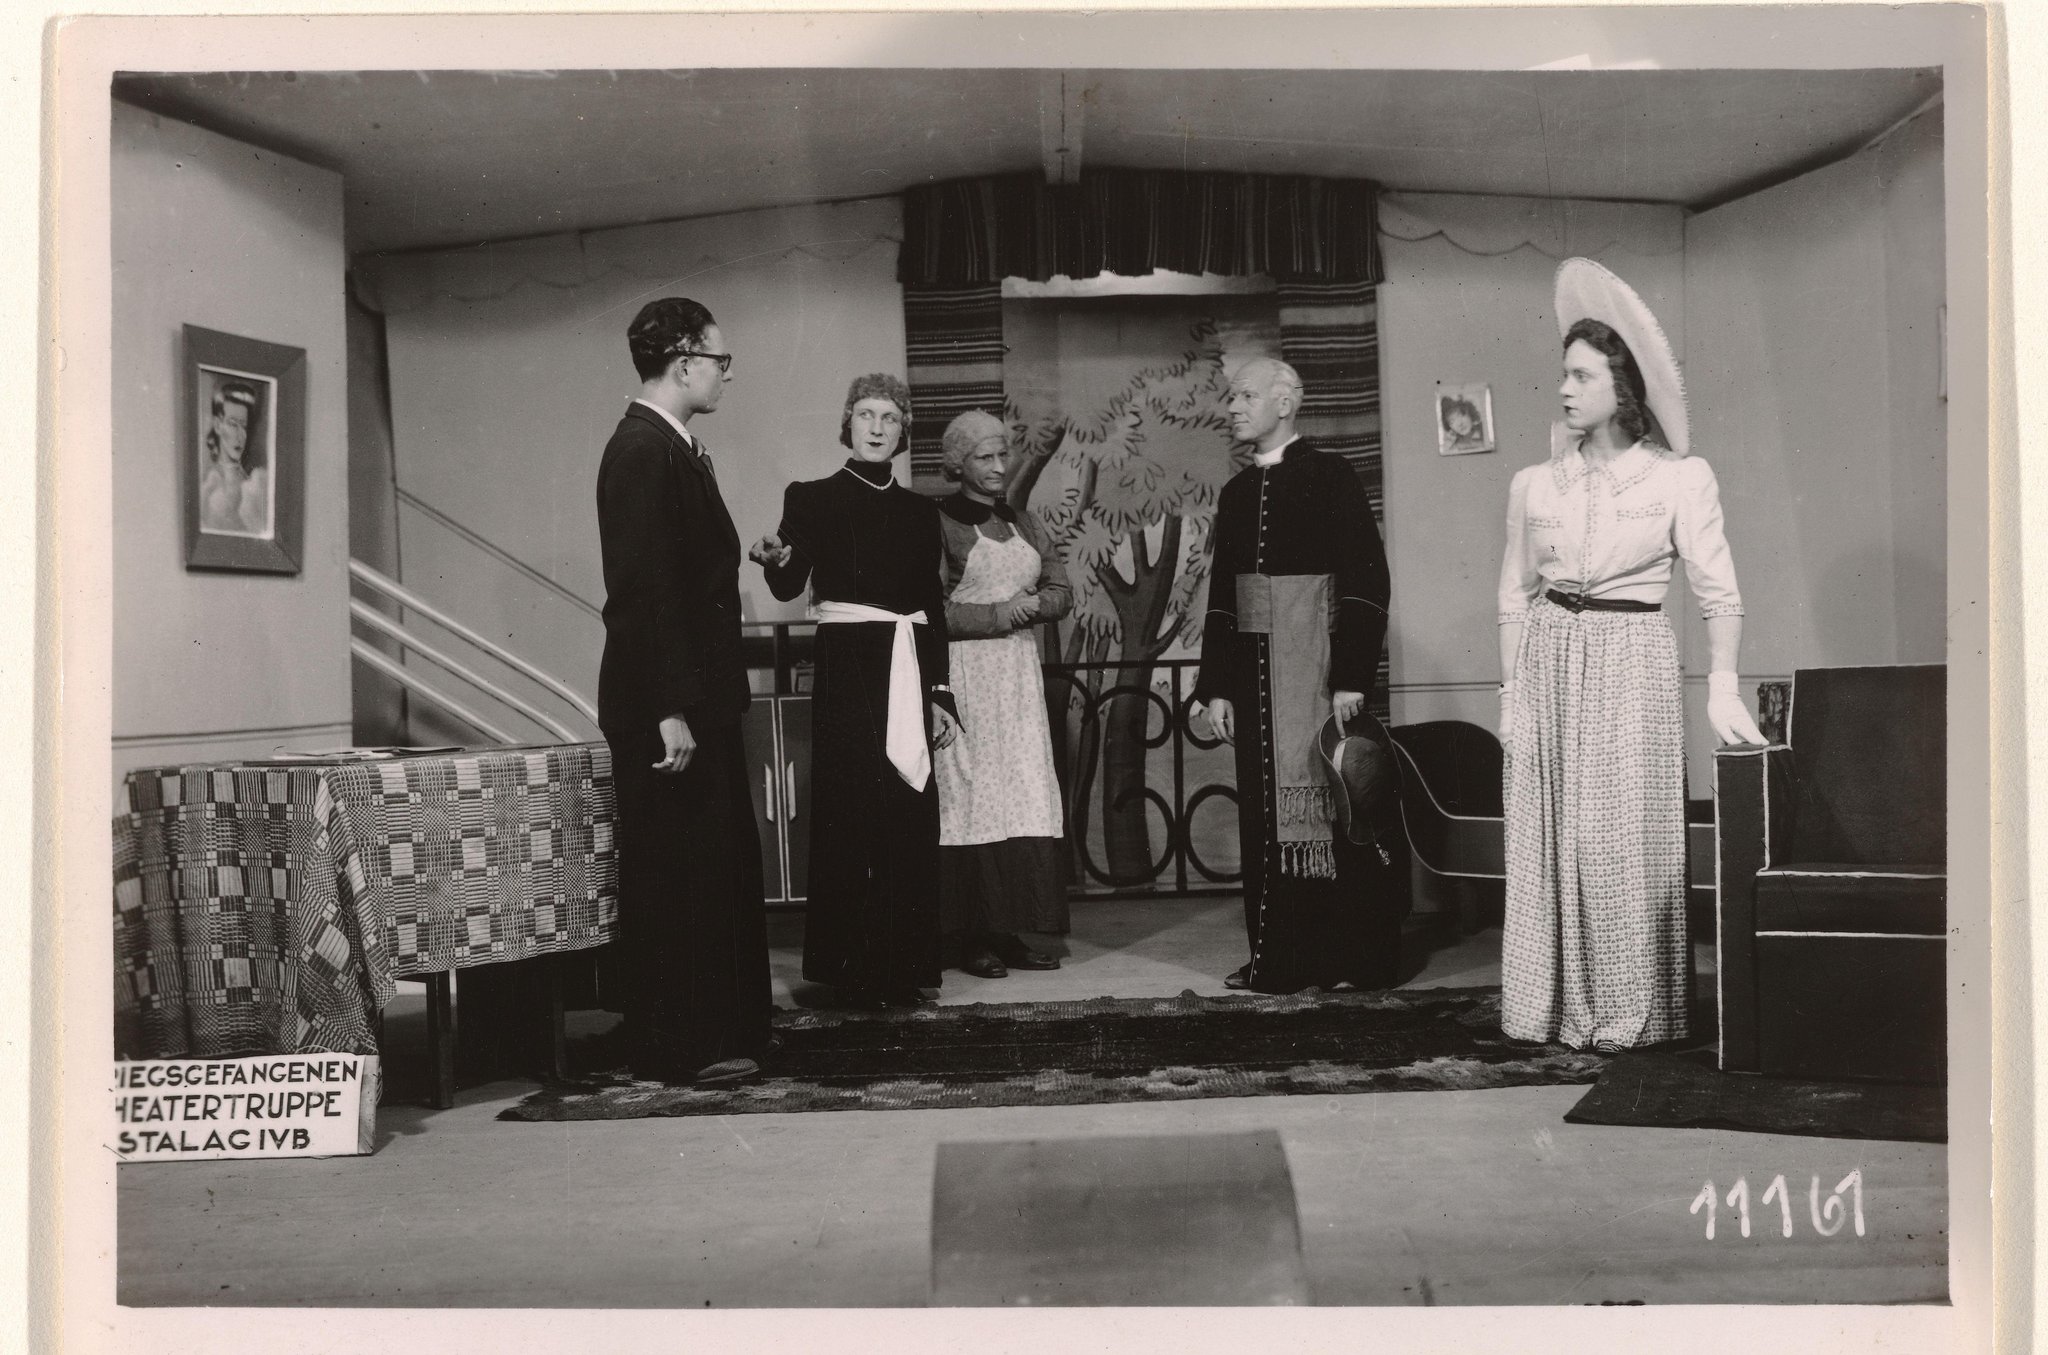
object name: photograph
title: Toneelstuk door krijgsgevangenen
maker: dick w.b. van maarseveen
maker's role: fotograaf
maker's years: 1905-1990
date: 1943-1945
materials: photographic support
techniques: gelatin silver print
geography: muhlberg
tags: the hague, dick w.b. van maarseveen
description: Toneelstuk opgevoerd door krijgsgevangenen in Kamp Mühlberg. Onderdeel van een groep foto's gemaakt door Dick van Maarseveen in het Duitse krijgsgevangenenkamp Stalag IV B in Mühlberg in de periode 1943-1945.